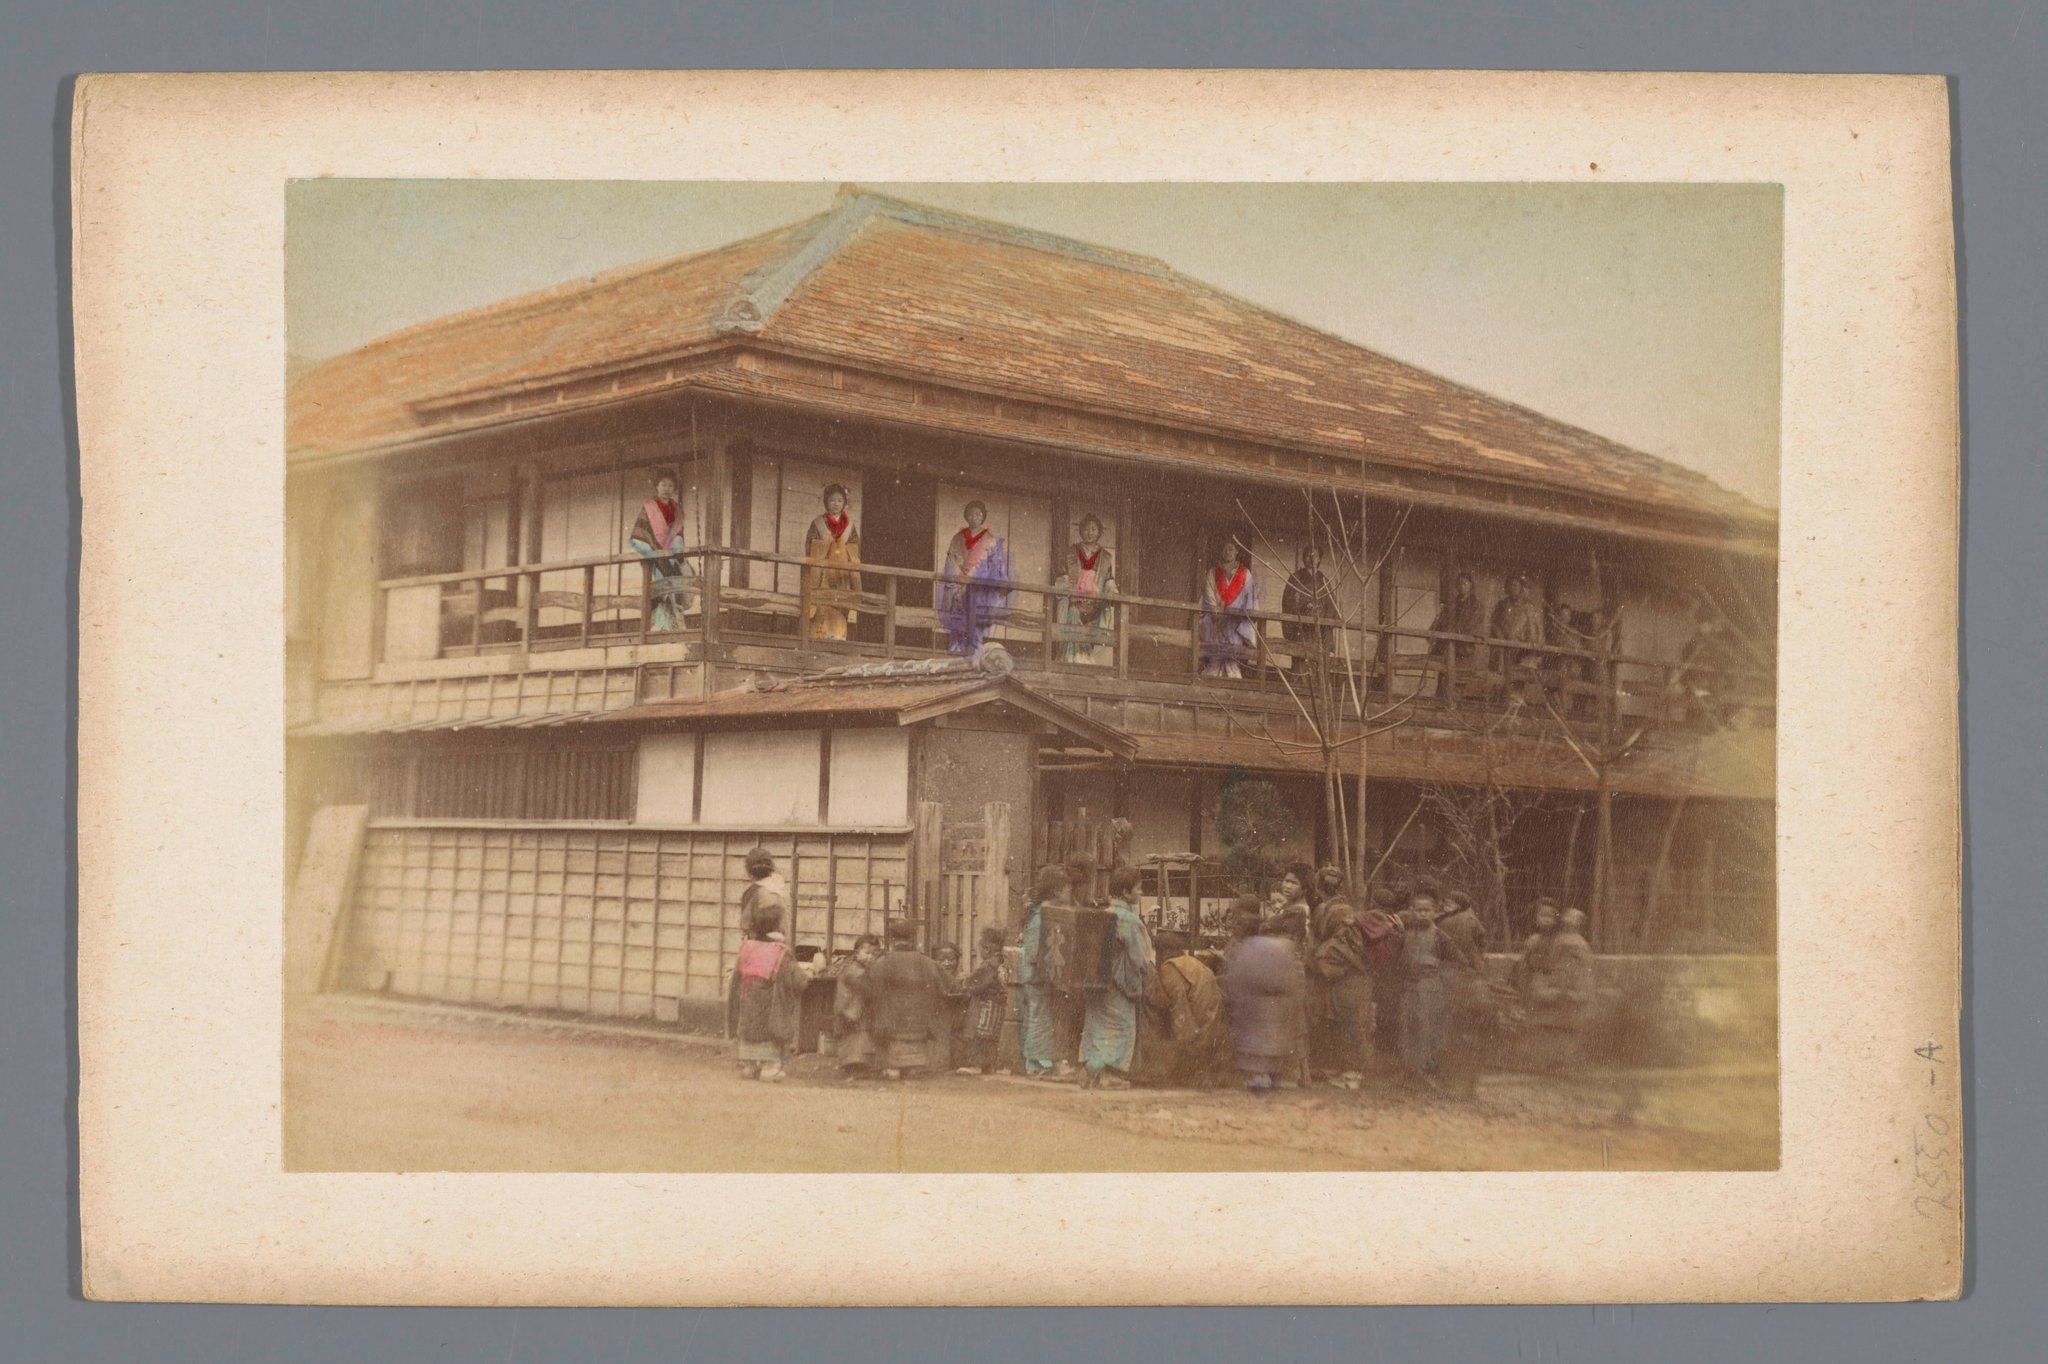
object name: photograph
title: Vrouwen en kinderen voor een gebouw in Japan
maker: Anonymous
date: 1860-1900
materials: cardboard, paper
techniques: albumen print, hand coloring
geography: japan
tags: adult woman, child, japan